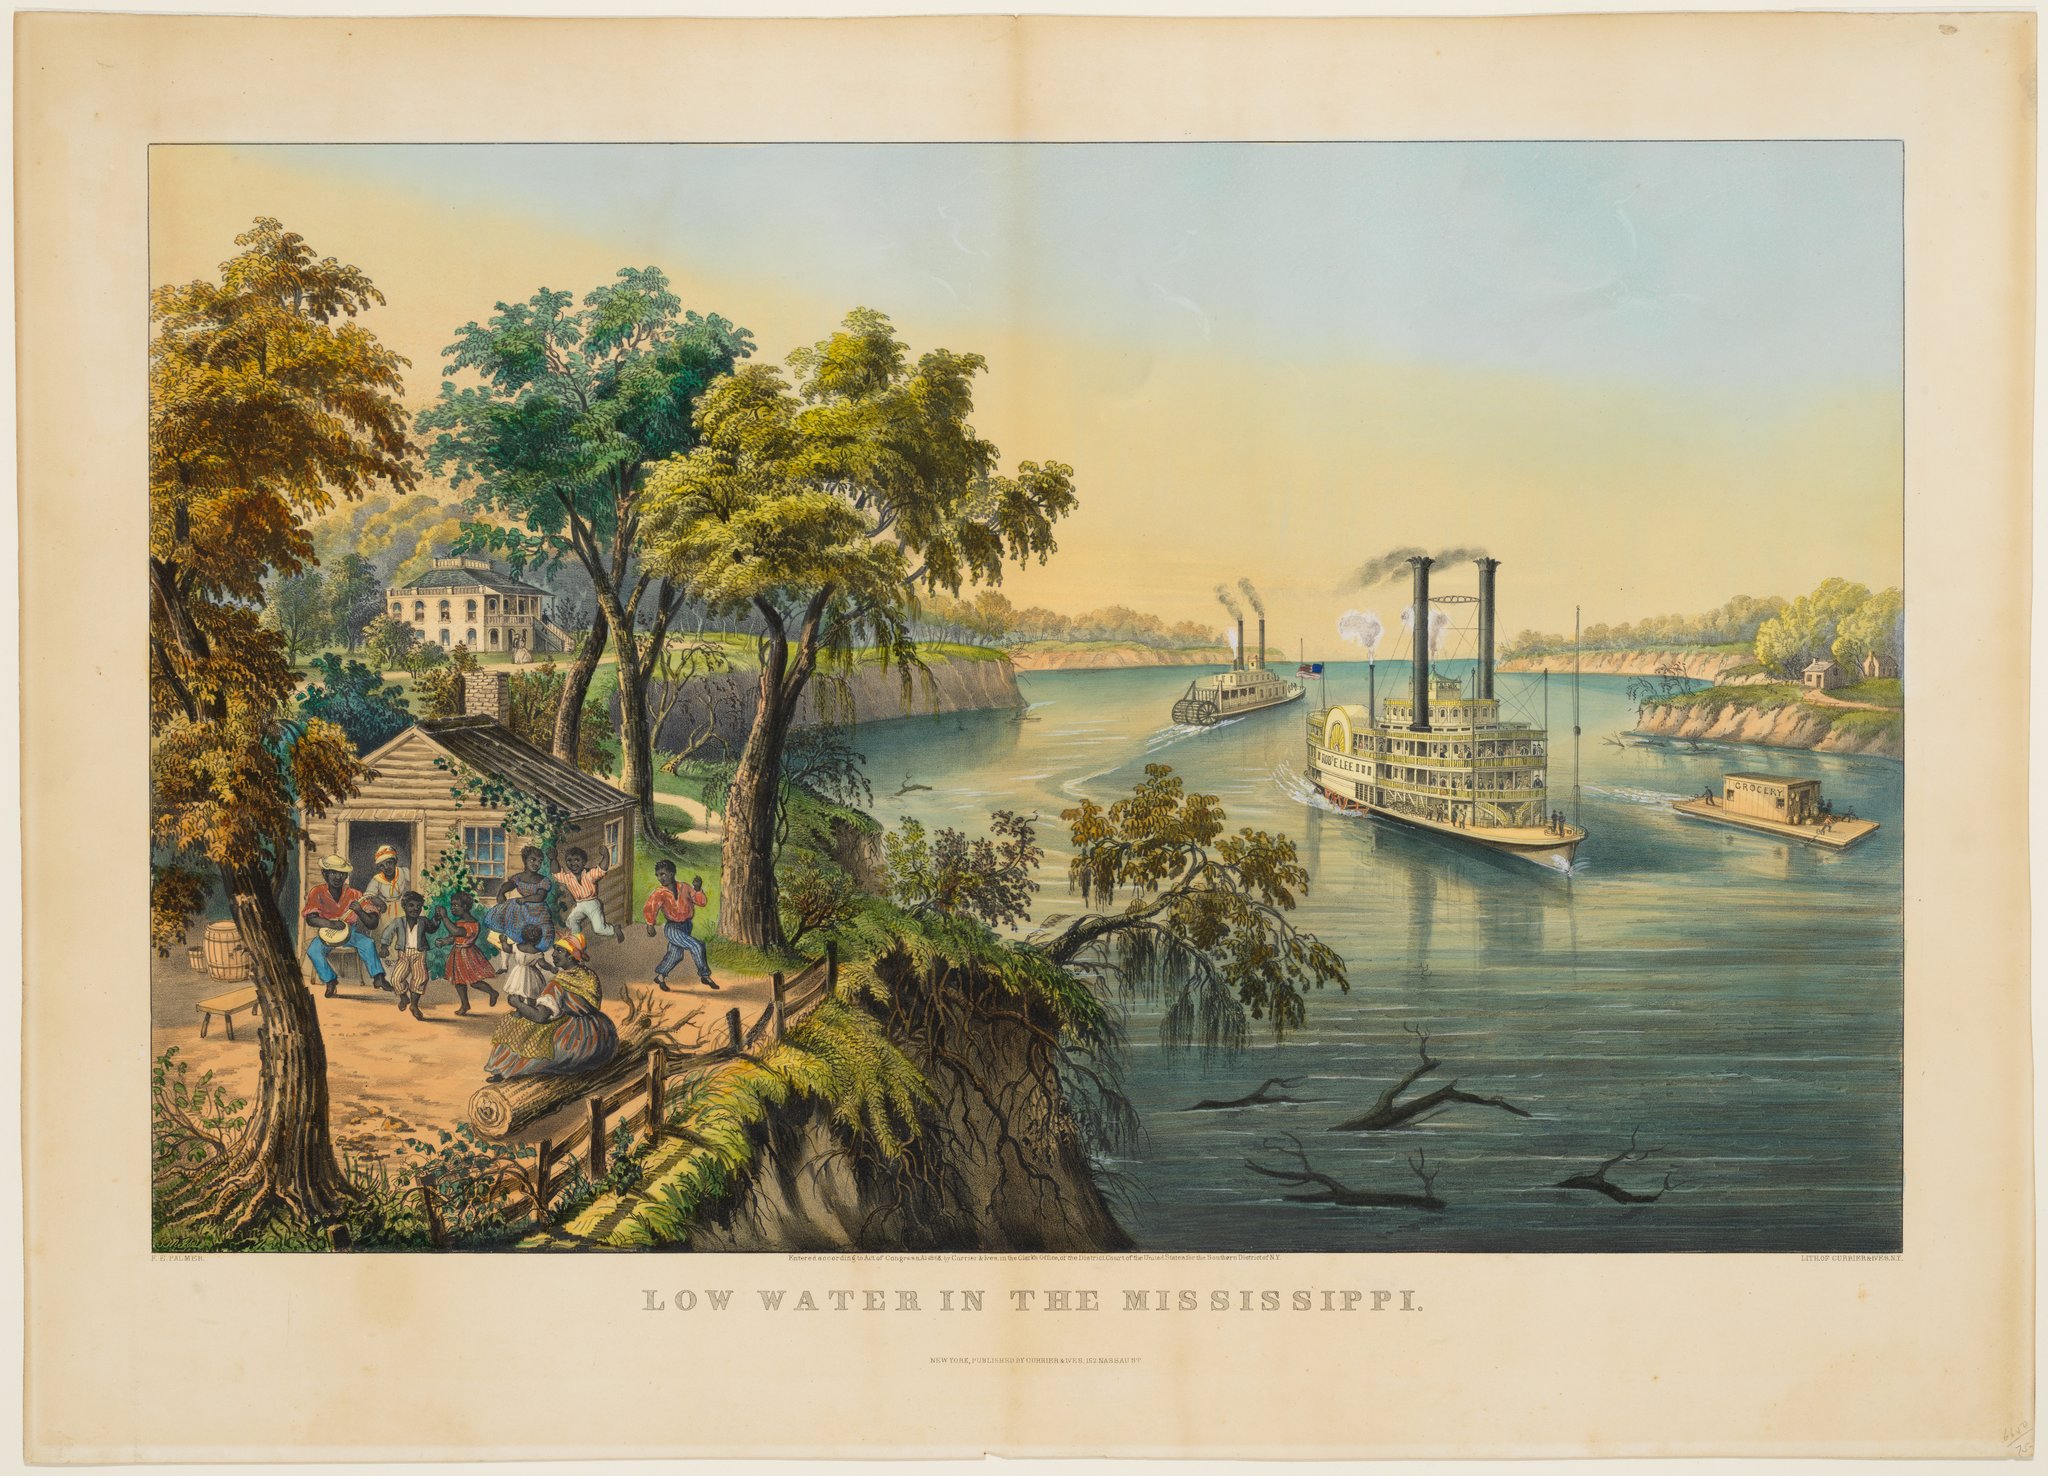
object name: print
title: Low Water in the Mississippi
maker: frances flora bond palmer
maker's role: artist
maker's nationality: american, born england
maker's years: 1812-1876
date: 1868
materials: gum arabic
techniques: hand coloring, lithograph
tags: rivers,boats